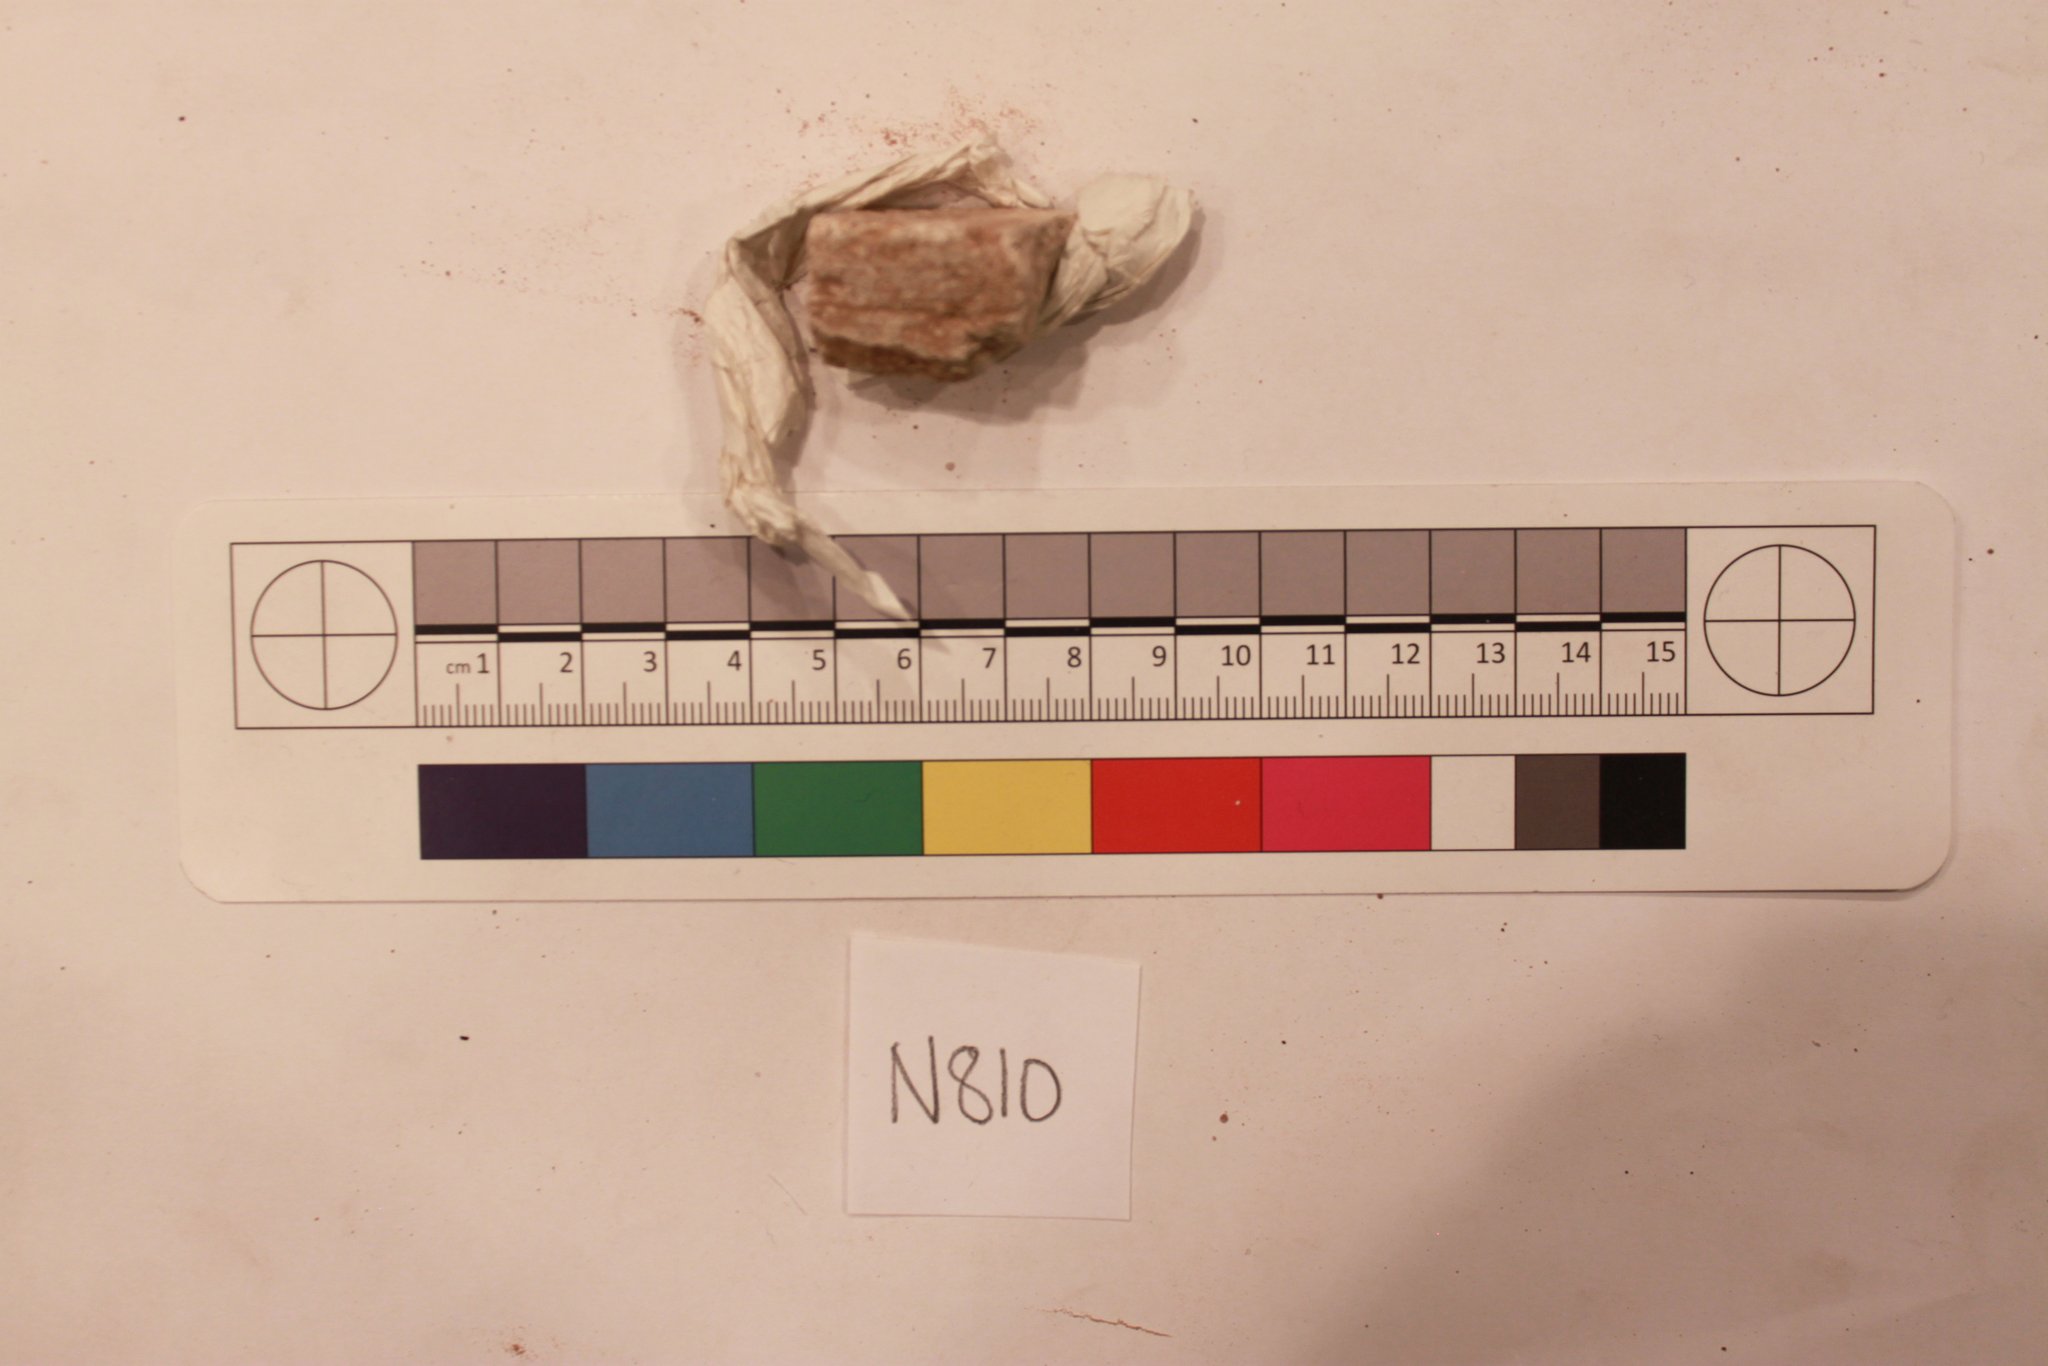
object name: fragment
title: Stucco Fragment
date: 701-1200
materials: plaster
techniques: carving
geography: iran